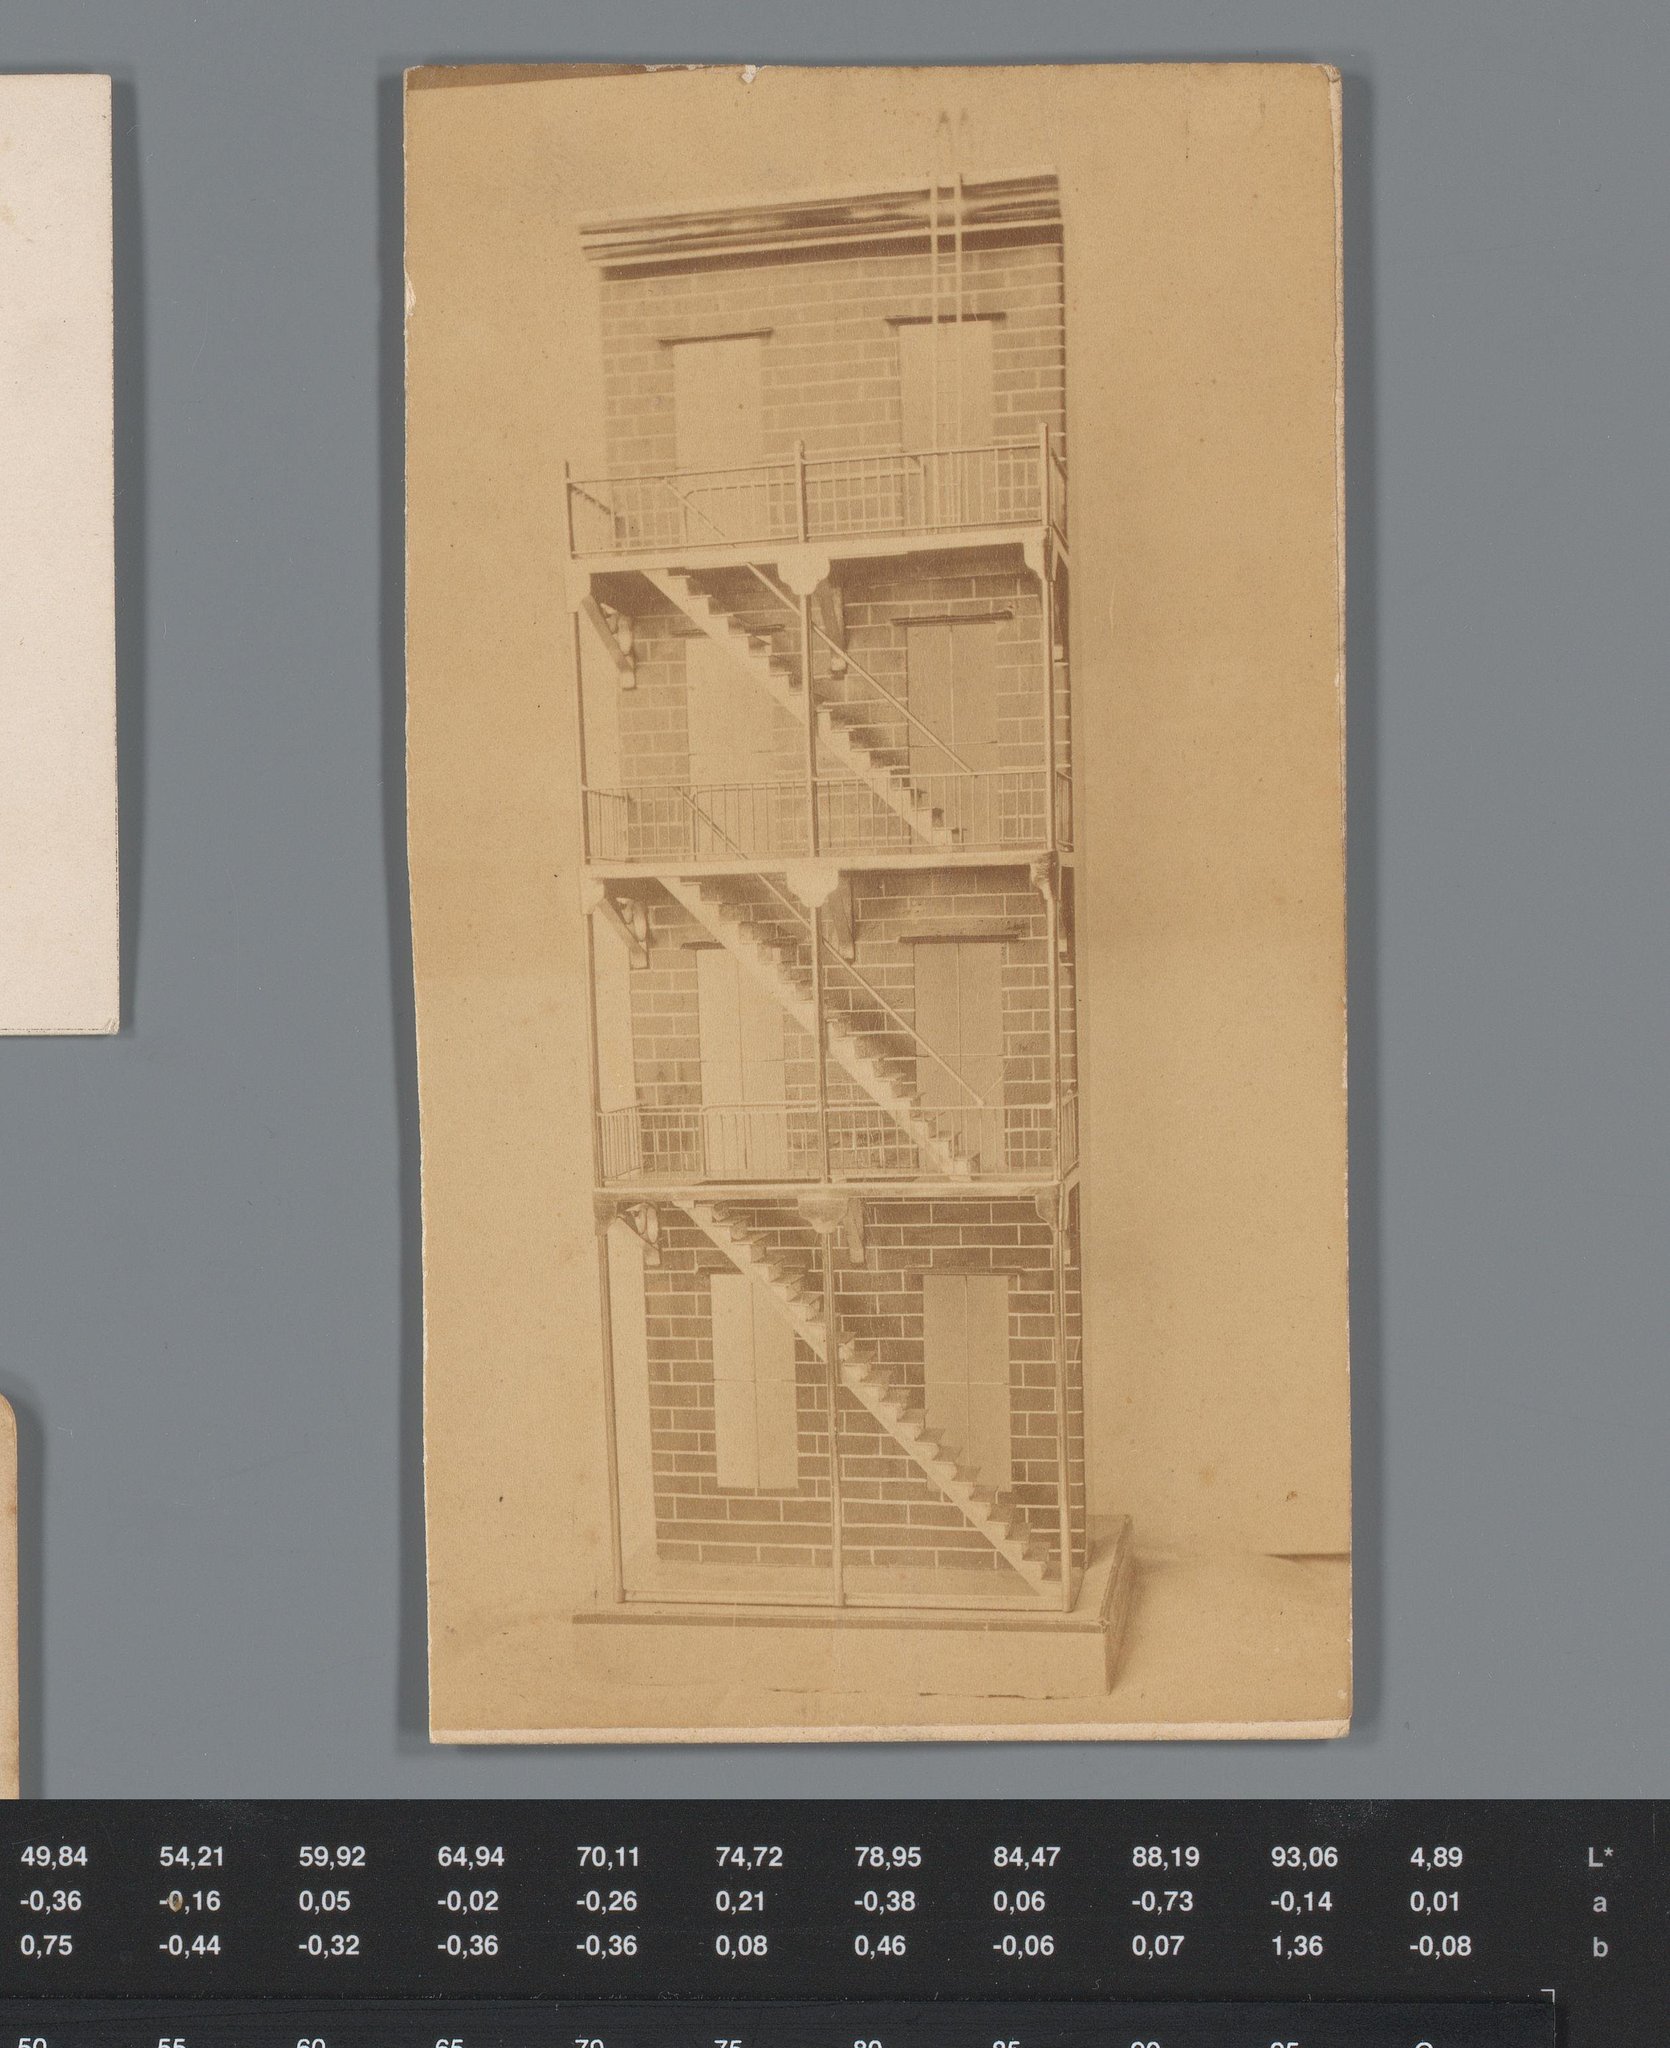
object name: carte de visite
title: Reclame voor een staalwerk van Edwards, Clarke & Co., Providence, met maquette van de voorzijde van een pand met stalen galerijen en brandtrappen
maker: Anonymous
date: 1850-1915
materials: cardboard, photographic support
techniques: albumen print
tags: bay-window, oriel, fire-escape, model ~ architecture, handicrafts ~ metal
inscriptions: stamp: ‘Presented by E.A. Rawson’, inscription: ‘EDWARDS, CLARKE & CO., / ARCHITECTURAL IRON AND METAL WORKS / Fancy and Ornamental Iron Work, / (...)’